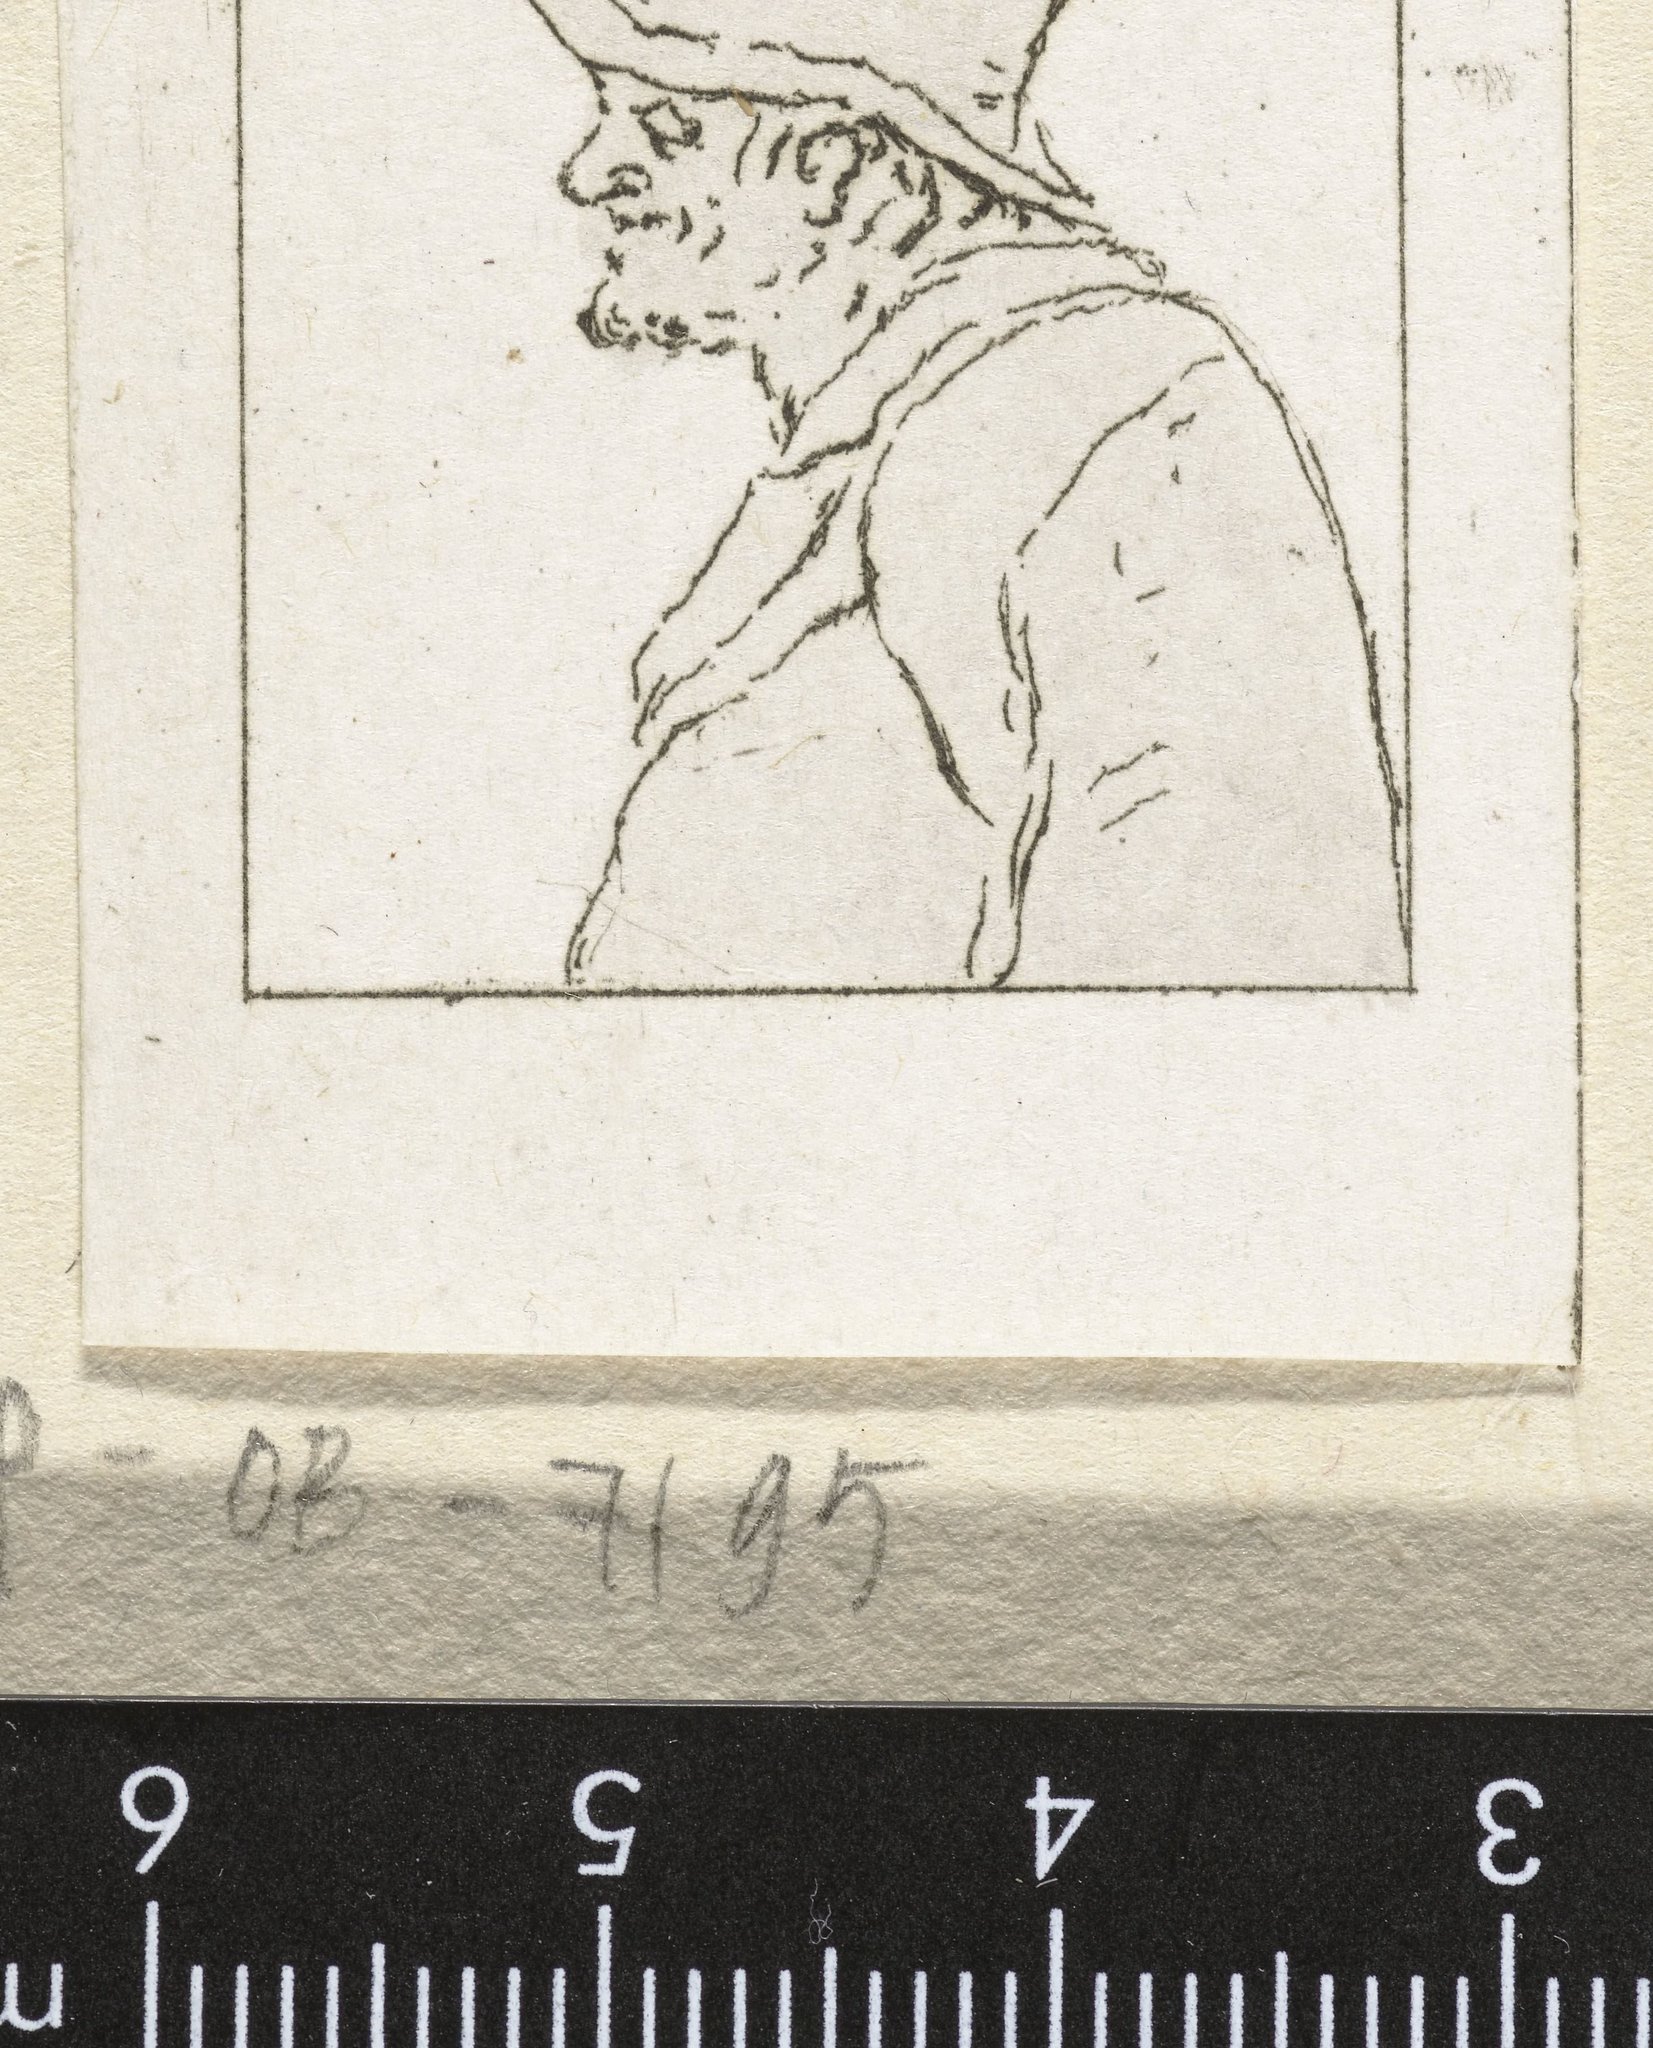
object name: print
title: Buste van een oude visser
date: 1779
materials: paper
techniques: brush, etching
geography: leiden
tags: morphology of human expression (+ old male (human being)), fisherman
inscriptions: collector's mark: Lugt 2228